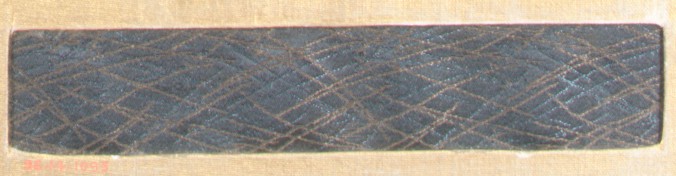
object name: piece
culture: japanese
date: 1701-1900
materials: silk